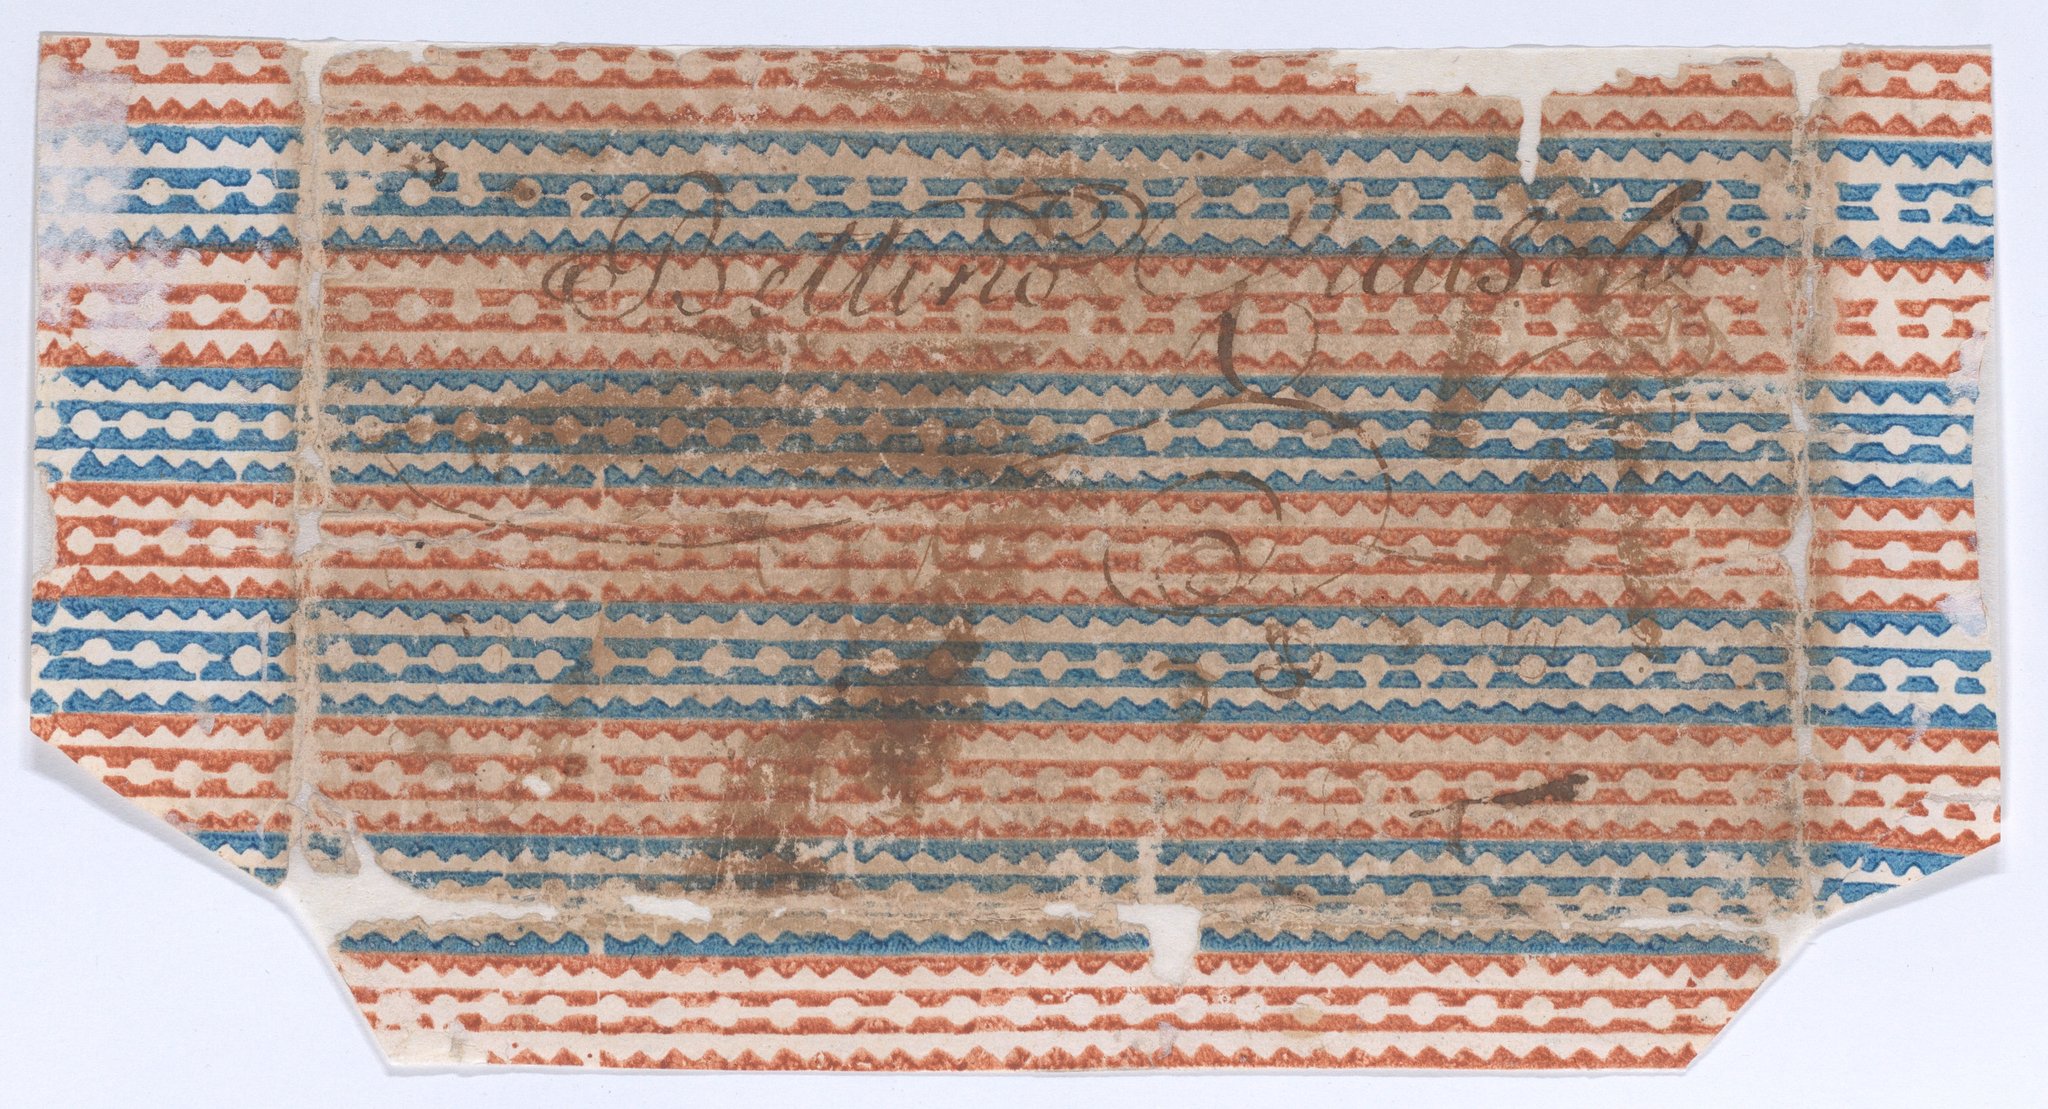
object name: print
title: Sheet with overall red and blue geometric pattern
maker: Anonymous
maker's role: artist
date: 1801-1900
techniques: relief print